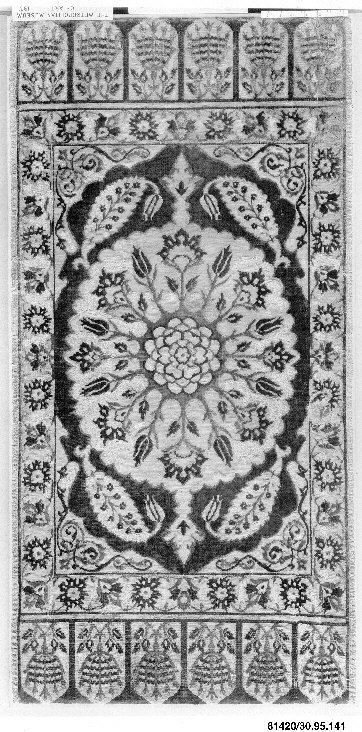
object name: panel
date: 1601-1700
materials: metal thread, silk, velvet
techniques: cutting, voiding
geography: turkey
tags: flowers